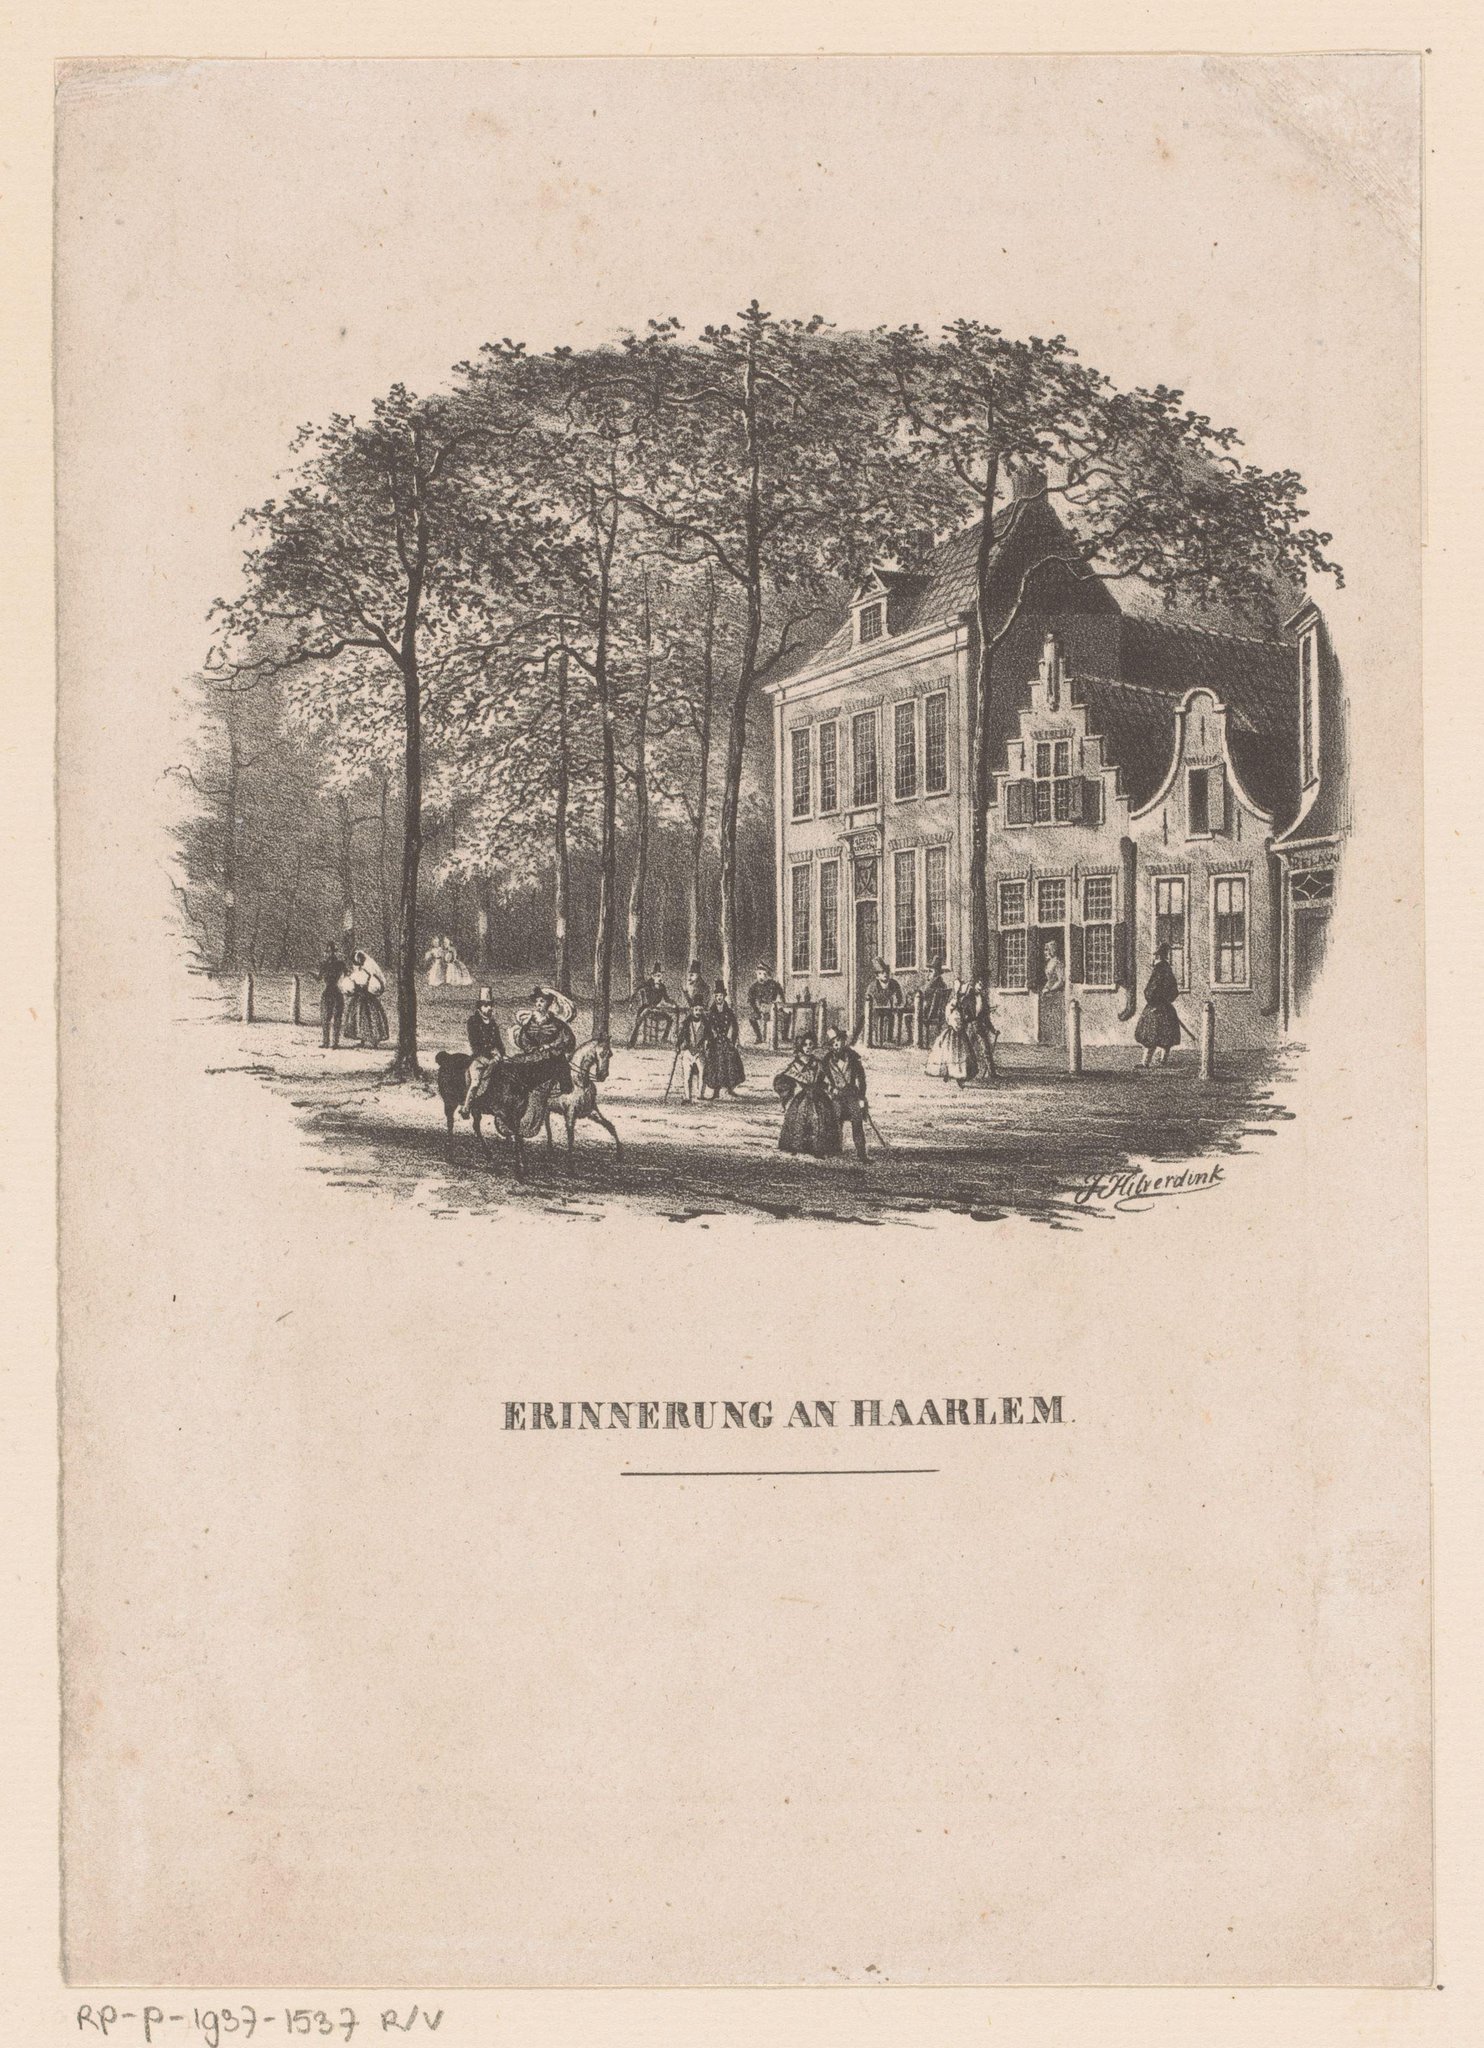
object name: print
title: Erinnerung an Haarlem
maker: jacob johannes josephus hilverdink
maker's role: print maker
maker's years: 1840-1879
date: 1850-1879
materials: paper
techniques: lithograph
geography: amsterdam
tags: the usual house or row of houses, village square, place, city-view, and landscape with man-made constructions (+ city(-scape) with figures, staffage), haarlem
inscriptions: collector's mark: Lugt 2760, collector's mark: Lugt 2228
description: Op een plein onder de bomen wandelen en rijden figuren. Rechts een rij huizen, waarvan een met een trap- en een met een klokgevel.